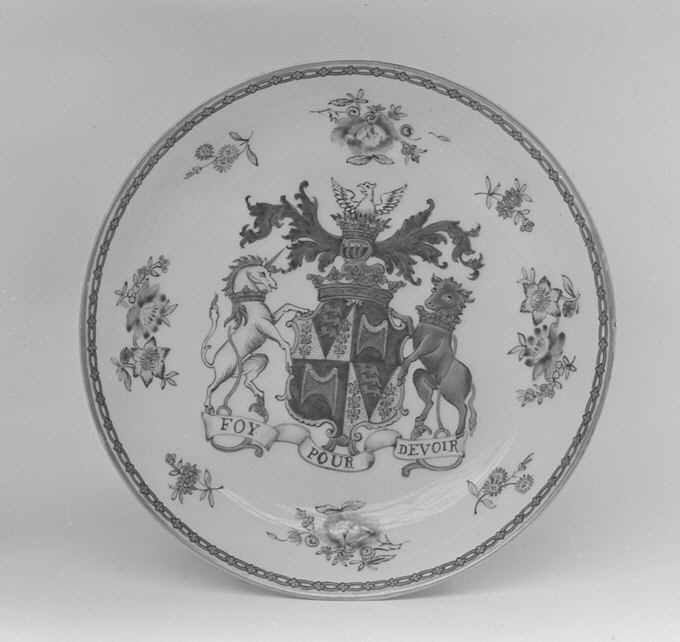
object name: saucer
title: Saucer (part of a service)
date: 1750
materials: hard paste porcelain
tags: flowers,coat of arms